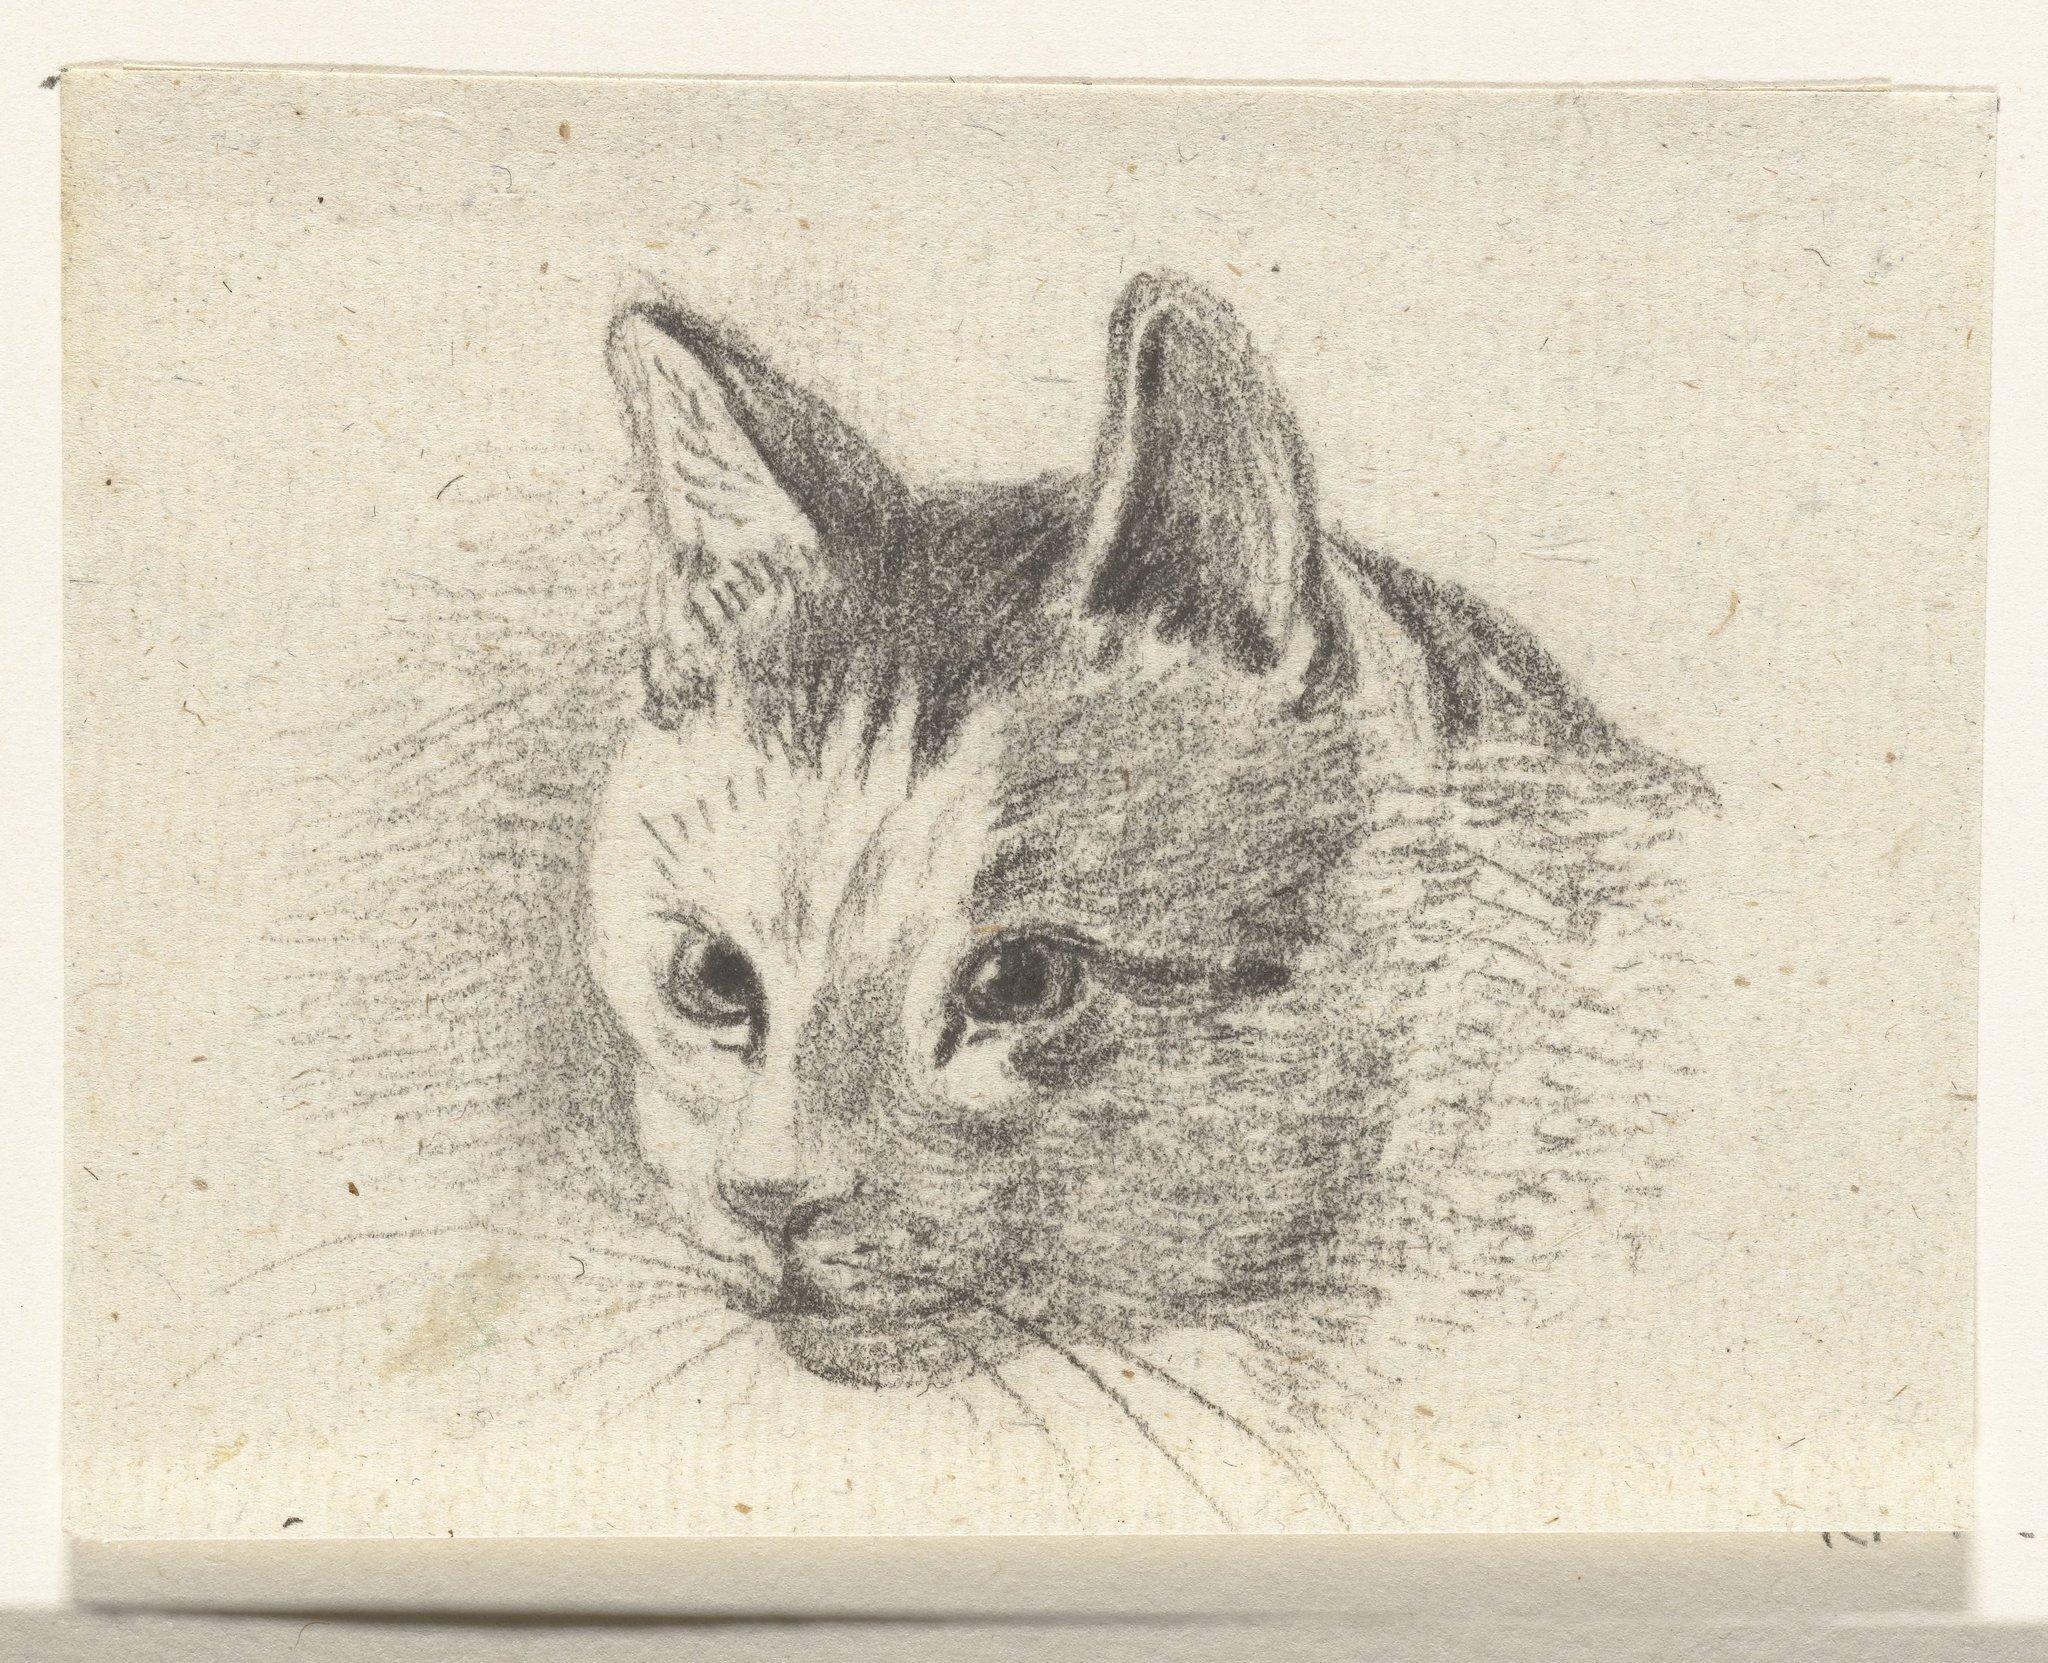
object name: drawing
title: Kop van een kat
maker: jean bernard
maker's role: draughtsman, print maker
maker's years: 1765-1833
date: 1775-1833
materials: chalk, paper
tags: cat